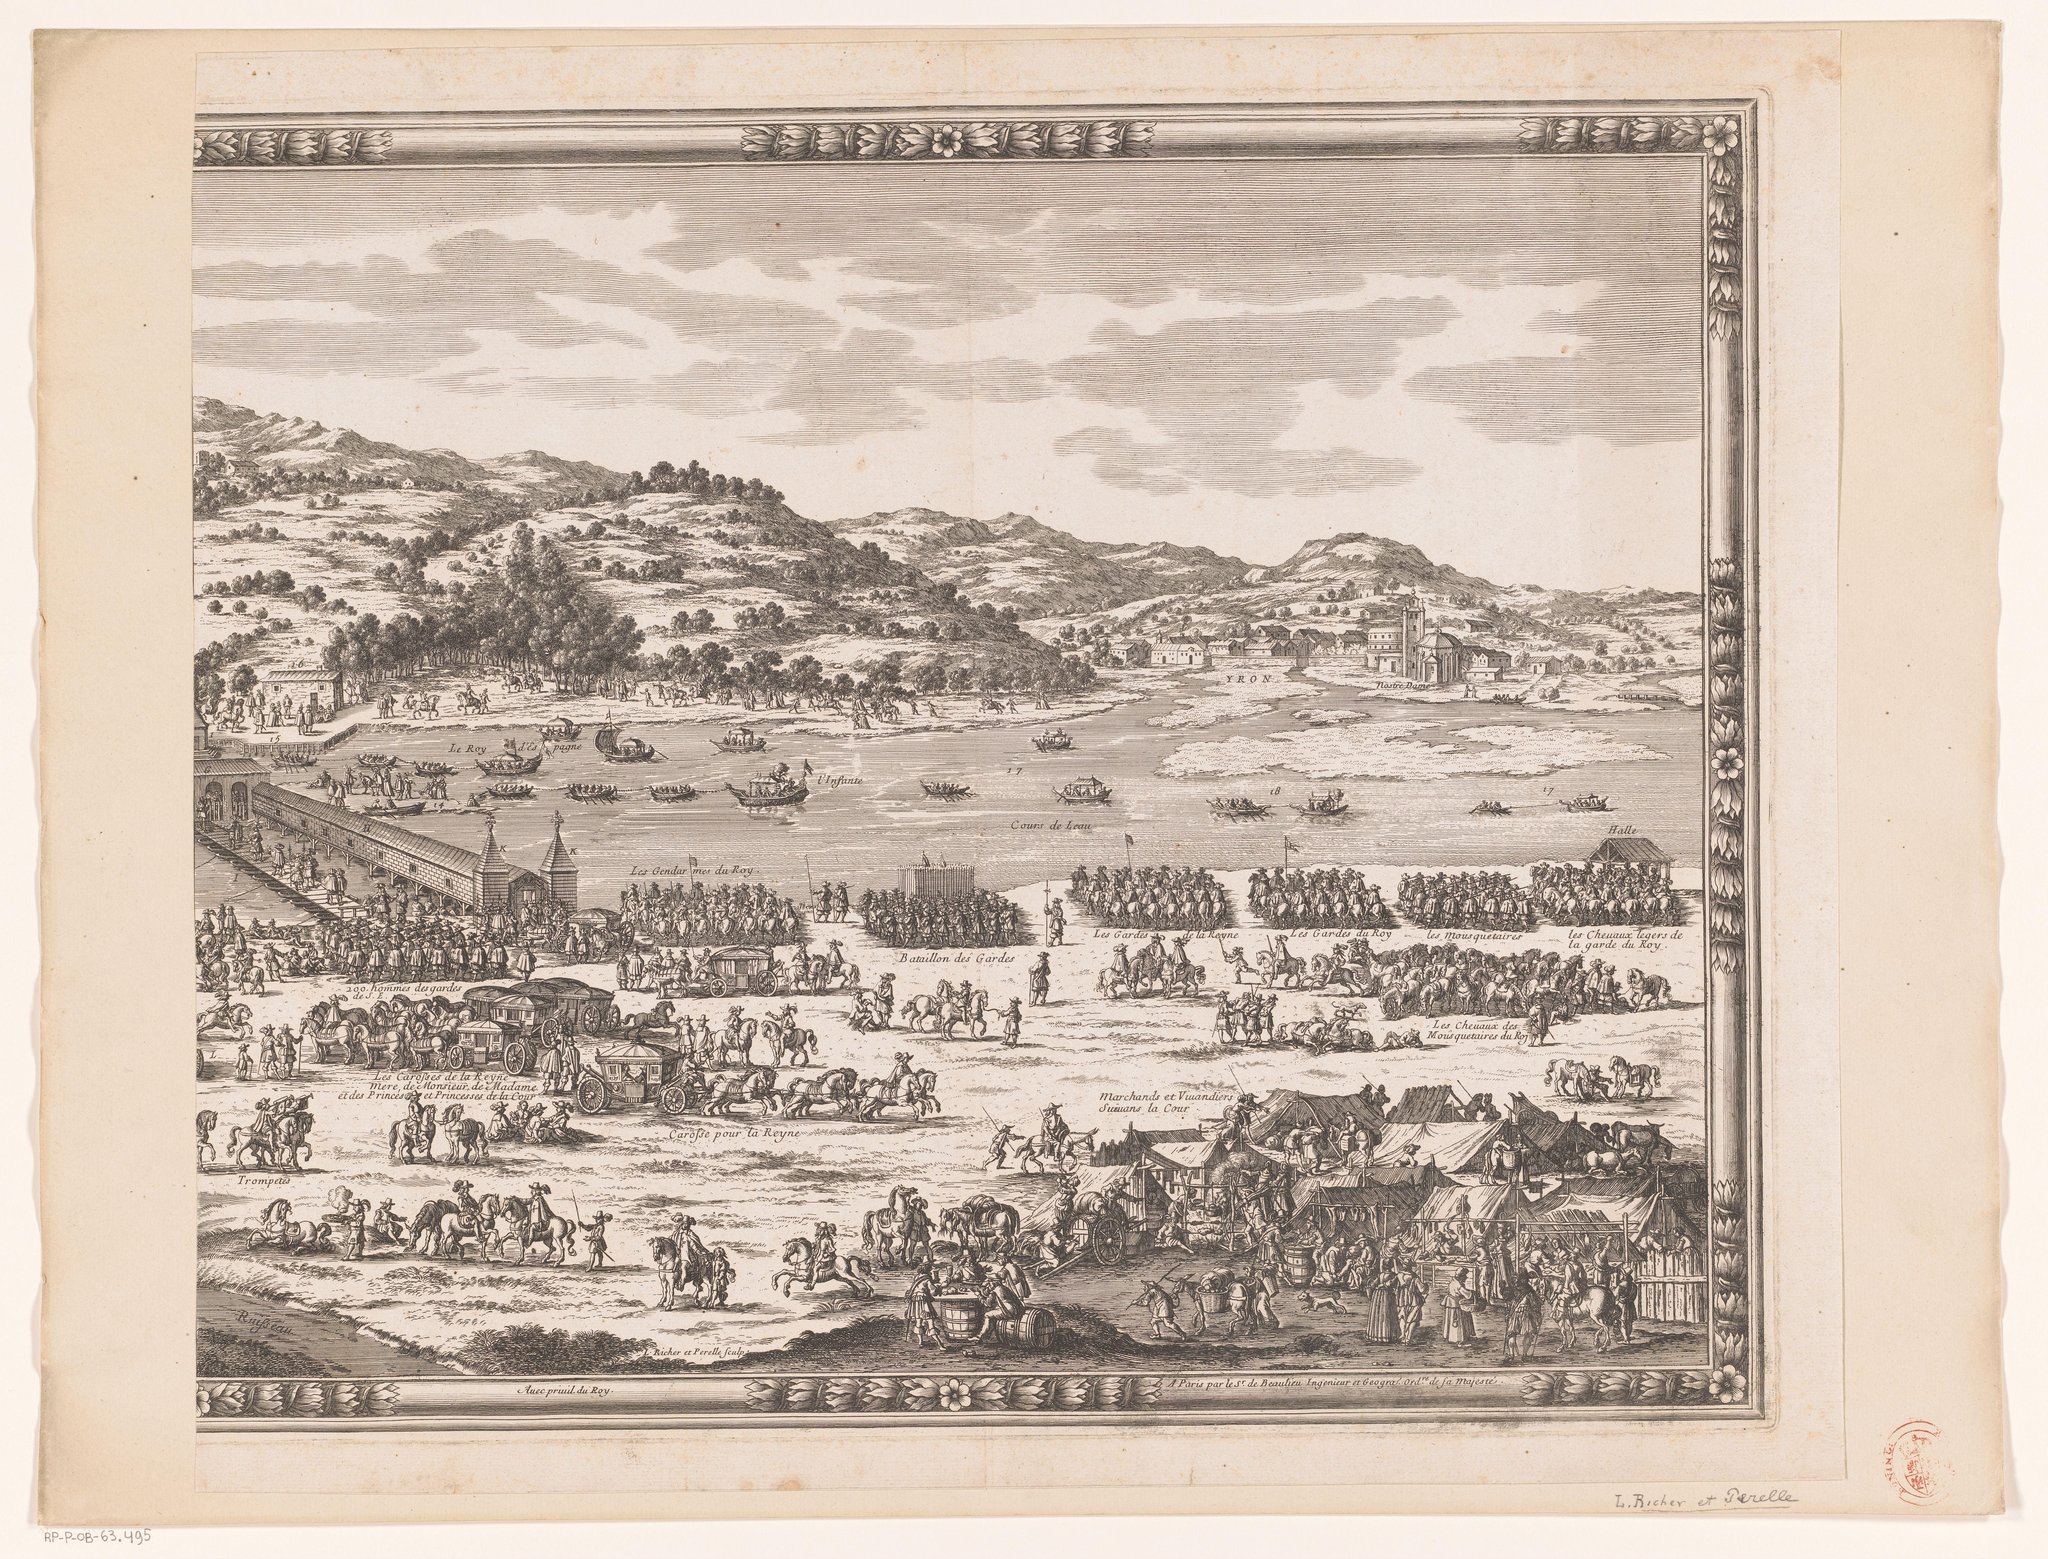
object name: print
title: Vredesconferentie op Île des Faisans met de koningen Lodewijk XIV en Filips IV (rechter deel)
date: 1660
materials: paper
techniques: etching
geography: france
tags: filips iv (koning van spanje), lodewijk xiv (koning van frankrijk), peace negotiations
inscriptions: collector's mark: Lugt 240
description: Aan weerszijden van de rivier arriveren de koningen met hun legers en hofhouding.